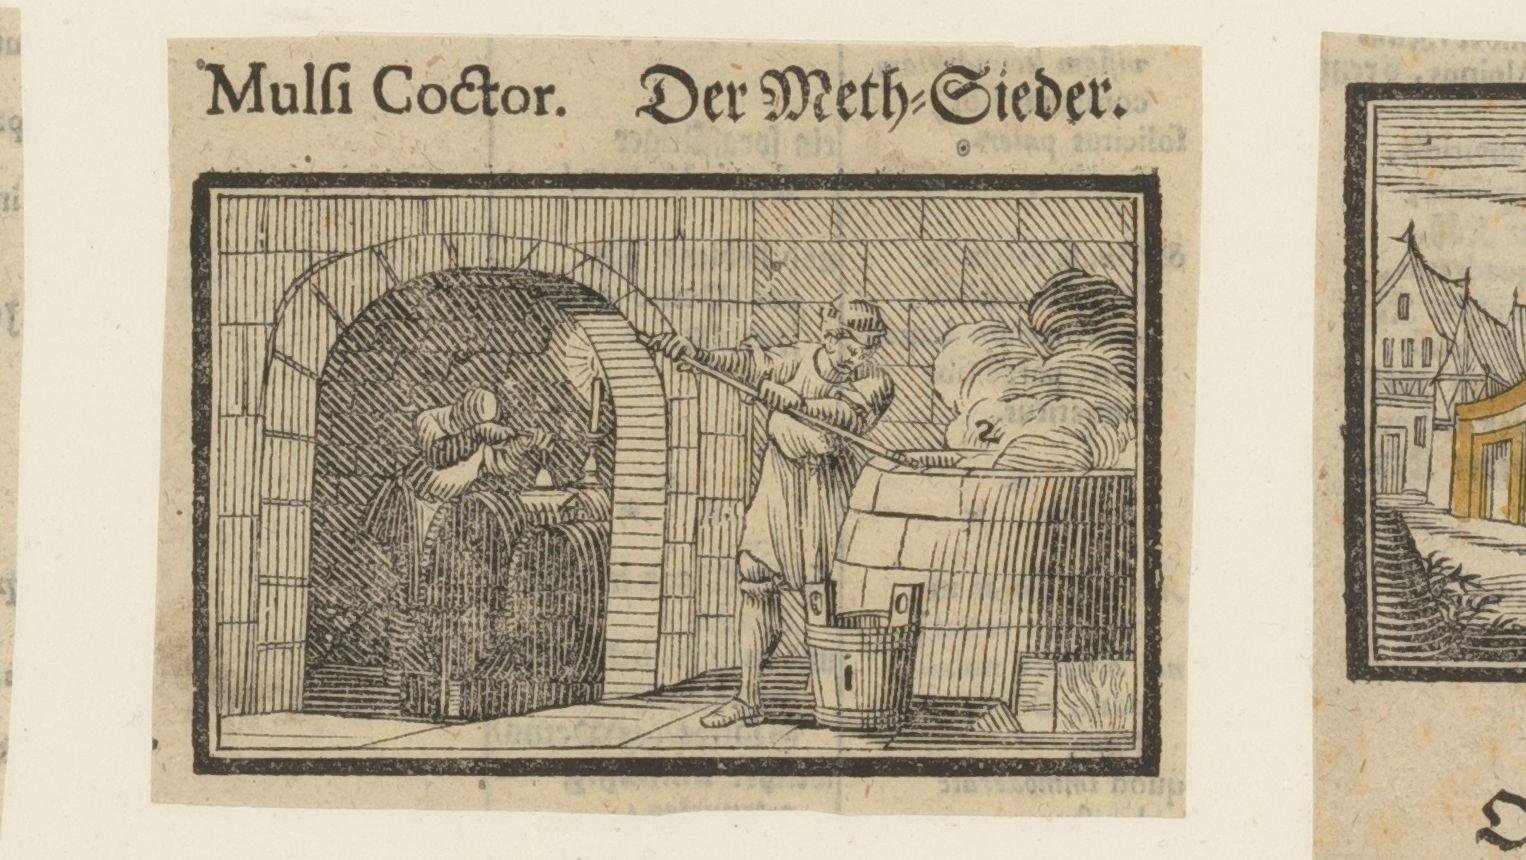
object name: book illustration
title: Medemaker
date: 1730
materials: paper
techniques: letterpress printing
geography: nuremberg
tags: handicrafts ~ production of food, drink, stimulants, etc., milk, churning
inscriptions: collector's mark: Lugt 1641, stamp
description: Mede of honingwijnmaker. Rechts roert een man in een dampend gemetseld vat. Op de grond een houten honingmaat. Door een poort ziet men een kelder met vaten en een tweede man. Onderwerpsrubrieken binnen de Atlas Zeden en Gewoonten: Handel, Nijverheid en Verkeer, Beroep en bedrijf, Complete suites.